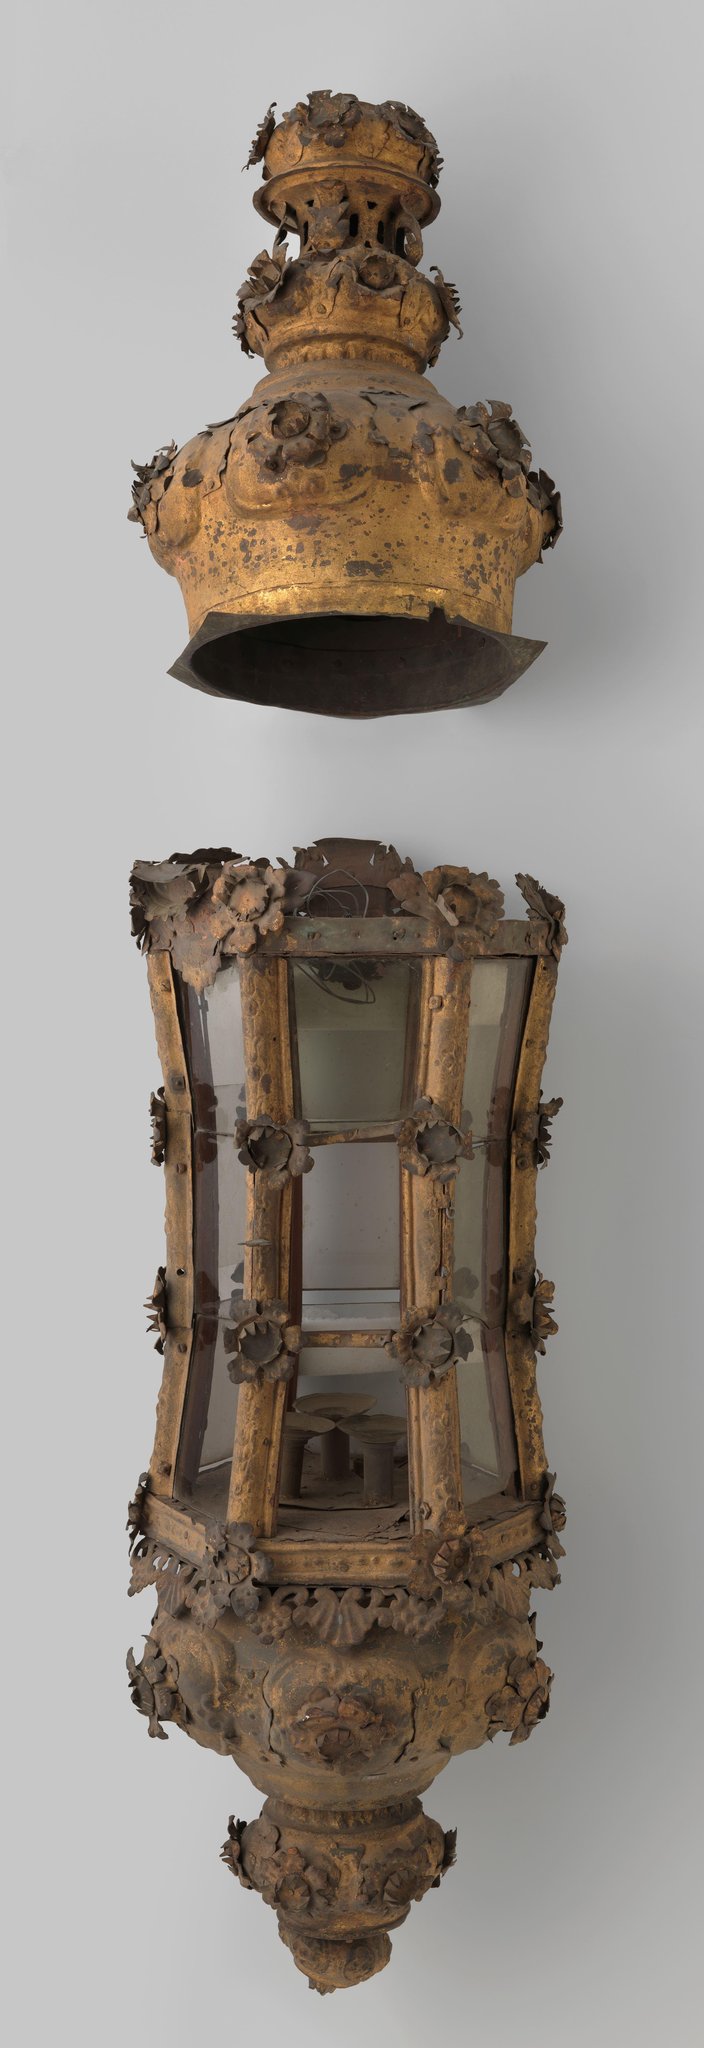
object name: lantern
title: Bodem van lantaarn met wapens boven de ruiten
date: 1700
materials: iron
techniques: gilding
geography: venice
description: De bodem van de lantaarn, omgekeerd gelijk aan het dak (zie BK-16969-A-1), echter zonder de laatste geleding. De lamp wordt versierd met rozetten. Afkomstig uit de verzameling Dr. F. Mannheimer.